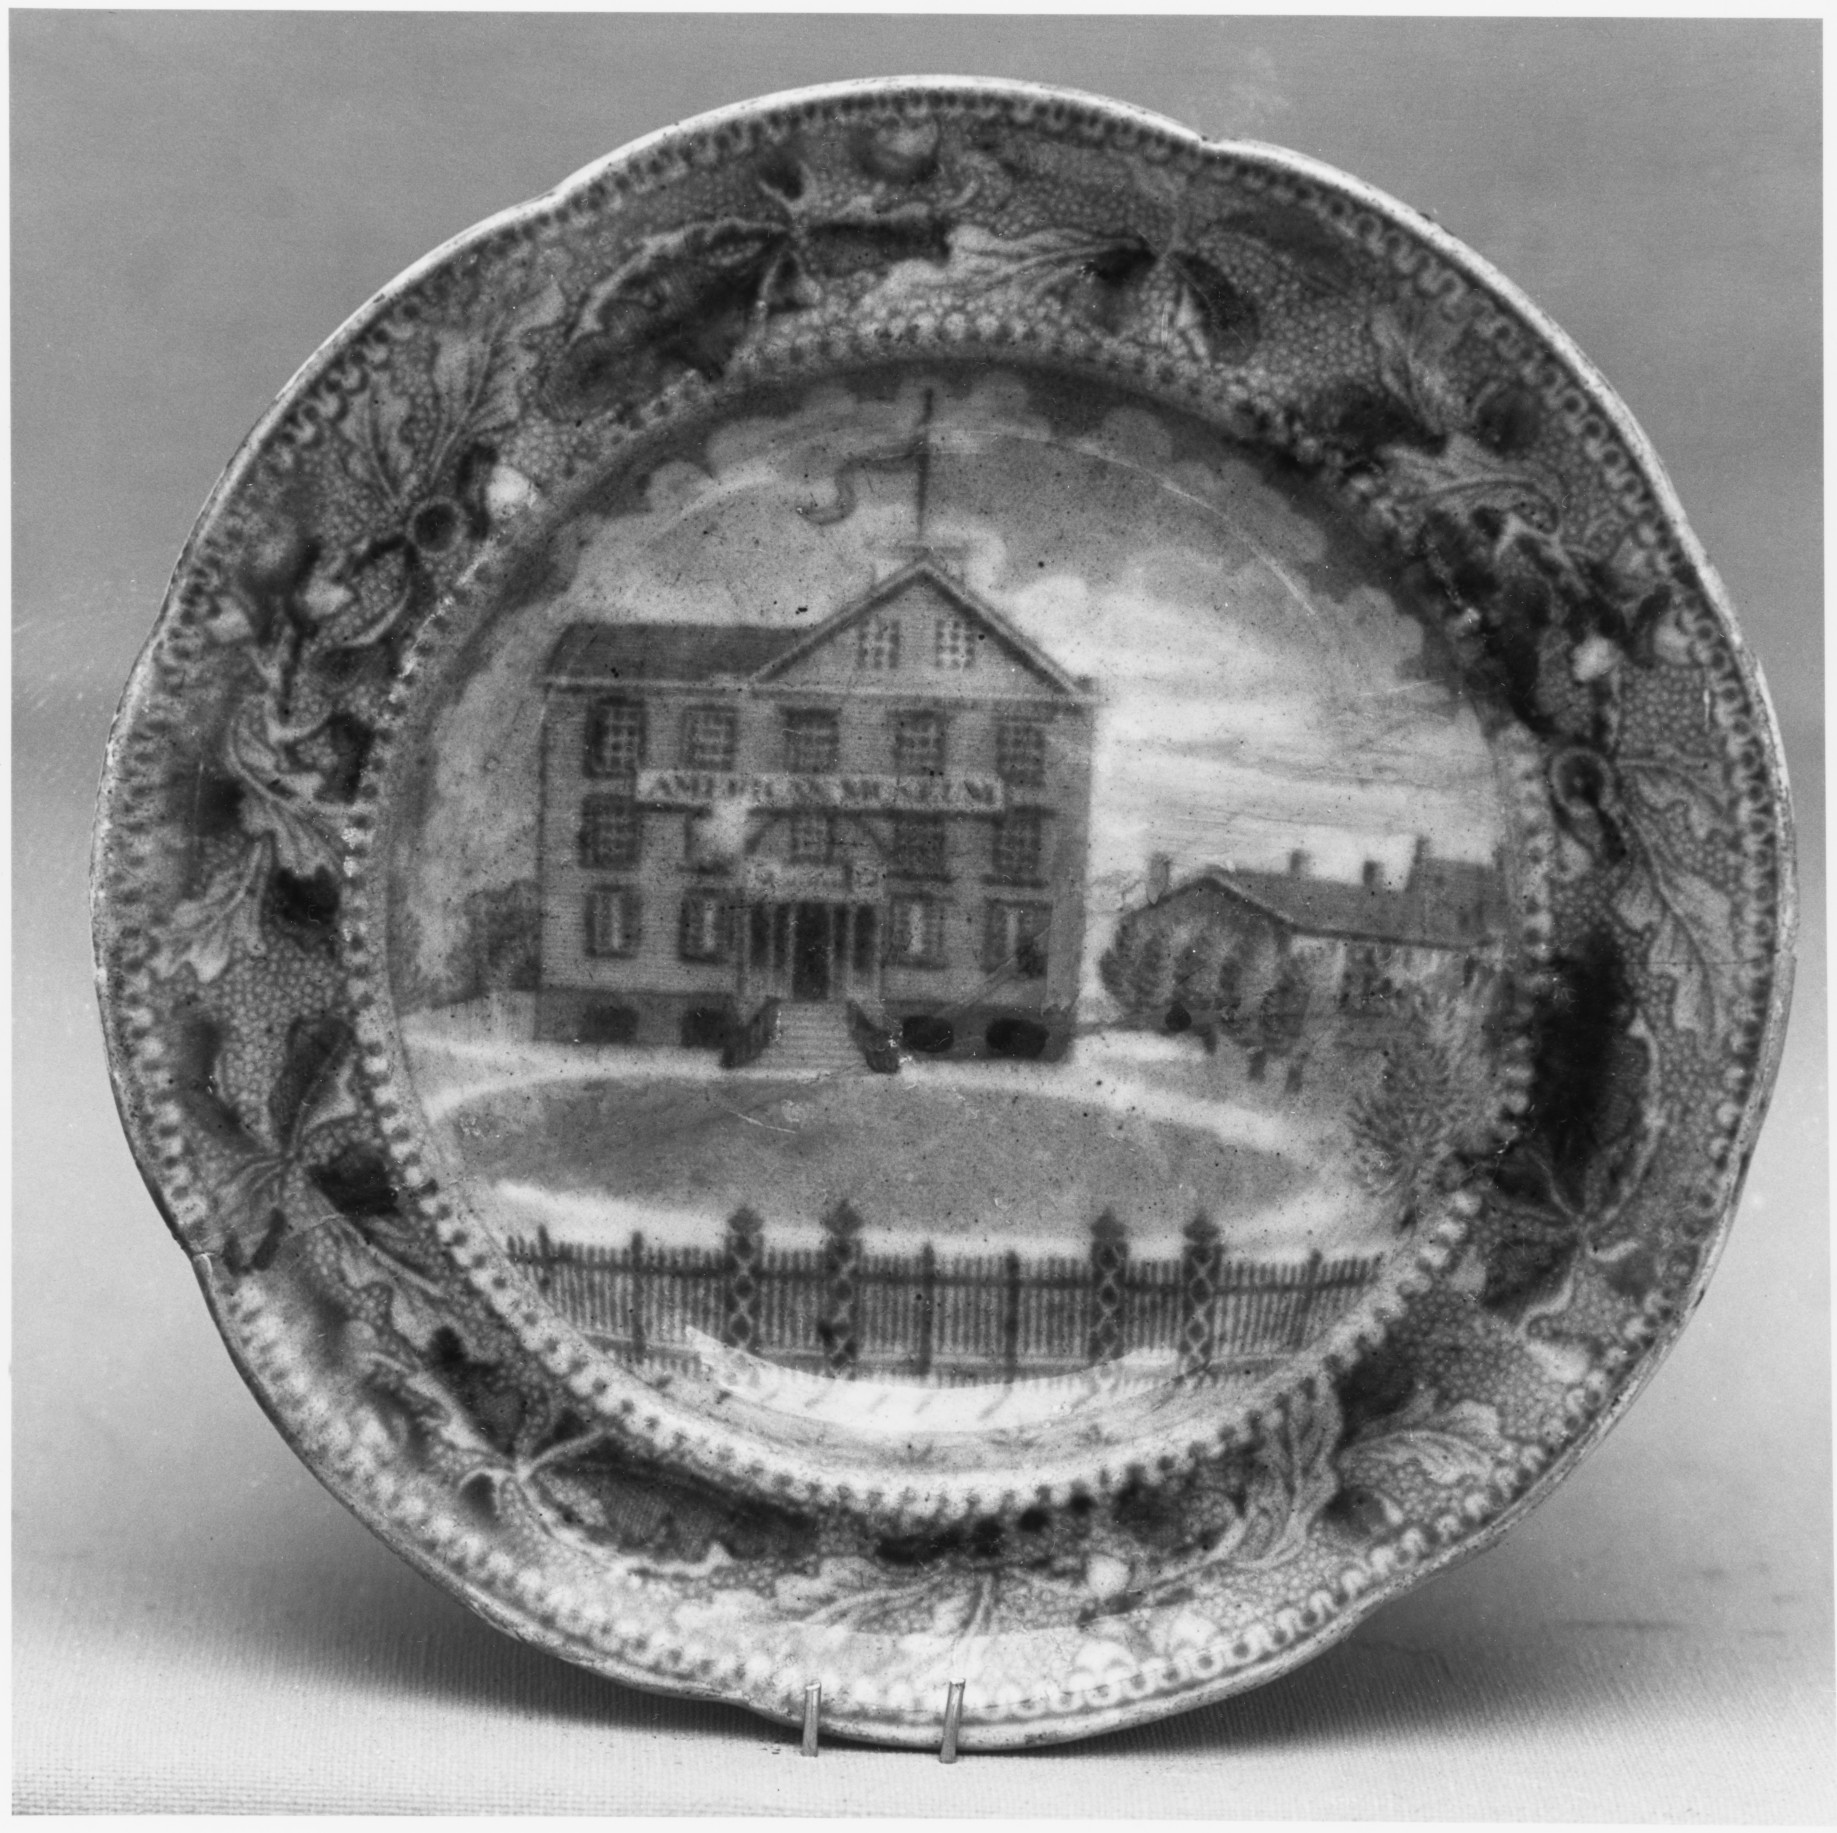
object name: cup plate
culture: british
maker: ralph stevenson & williams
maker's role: maker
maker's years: 1822-1827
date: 1825-1827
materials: earthenware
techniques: transfer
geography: england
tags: buildings,museums